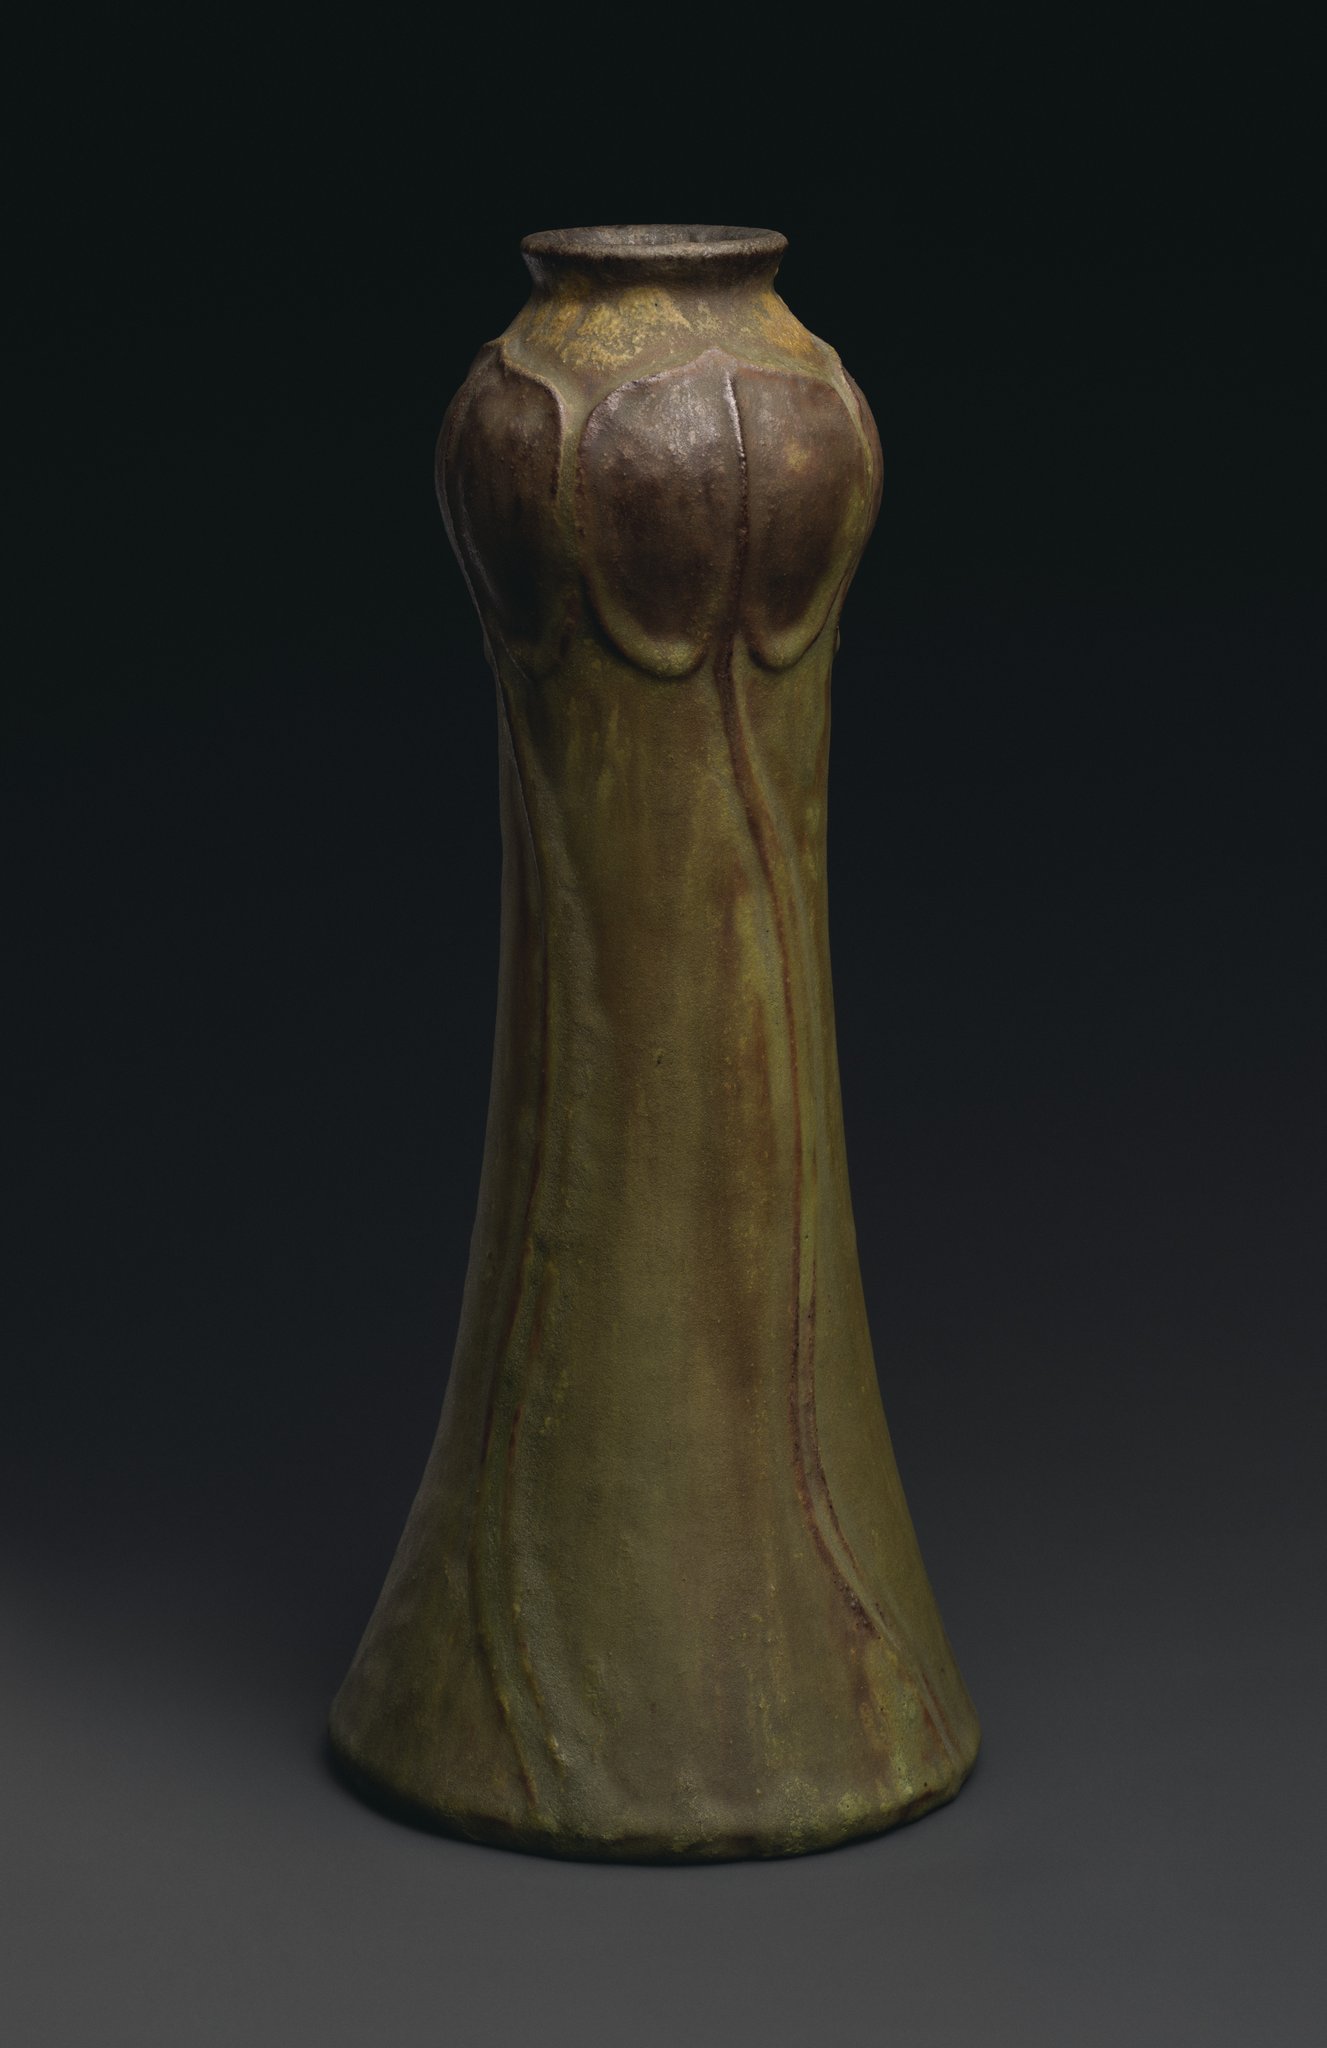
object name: candlestick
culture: american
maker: william j. walley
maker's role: maker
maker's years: 1852-1919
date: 1898-1918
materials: earthenware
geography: united states